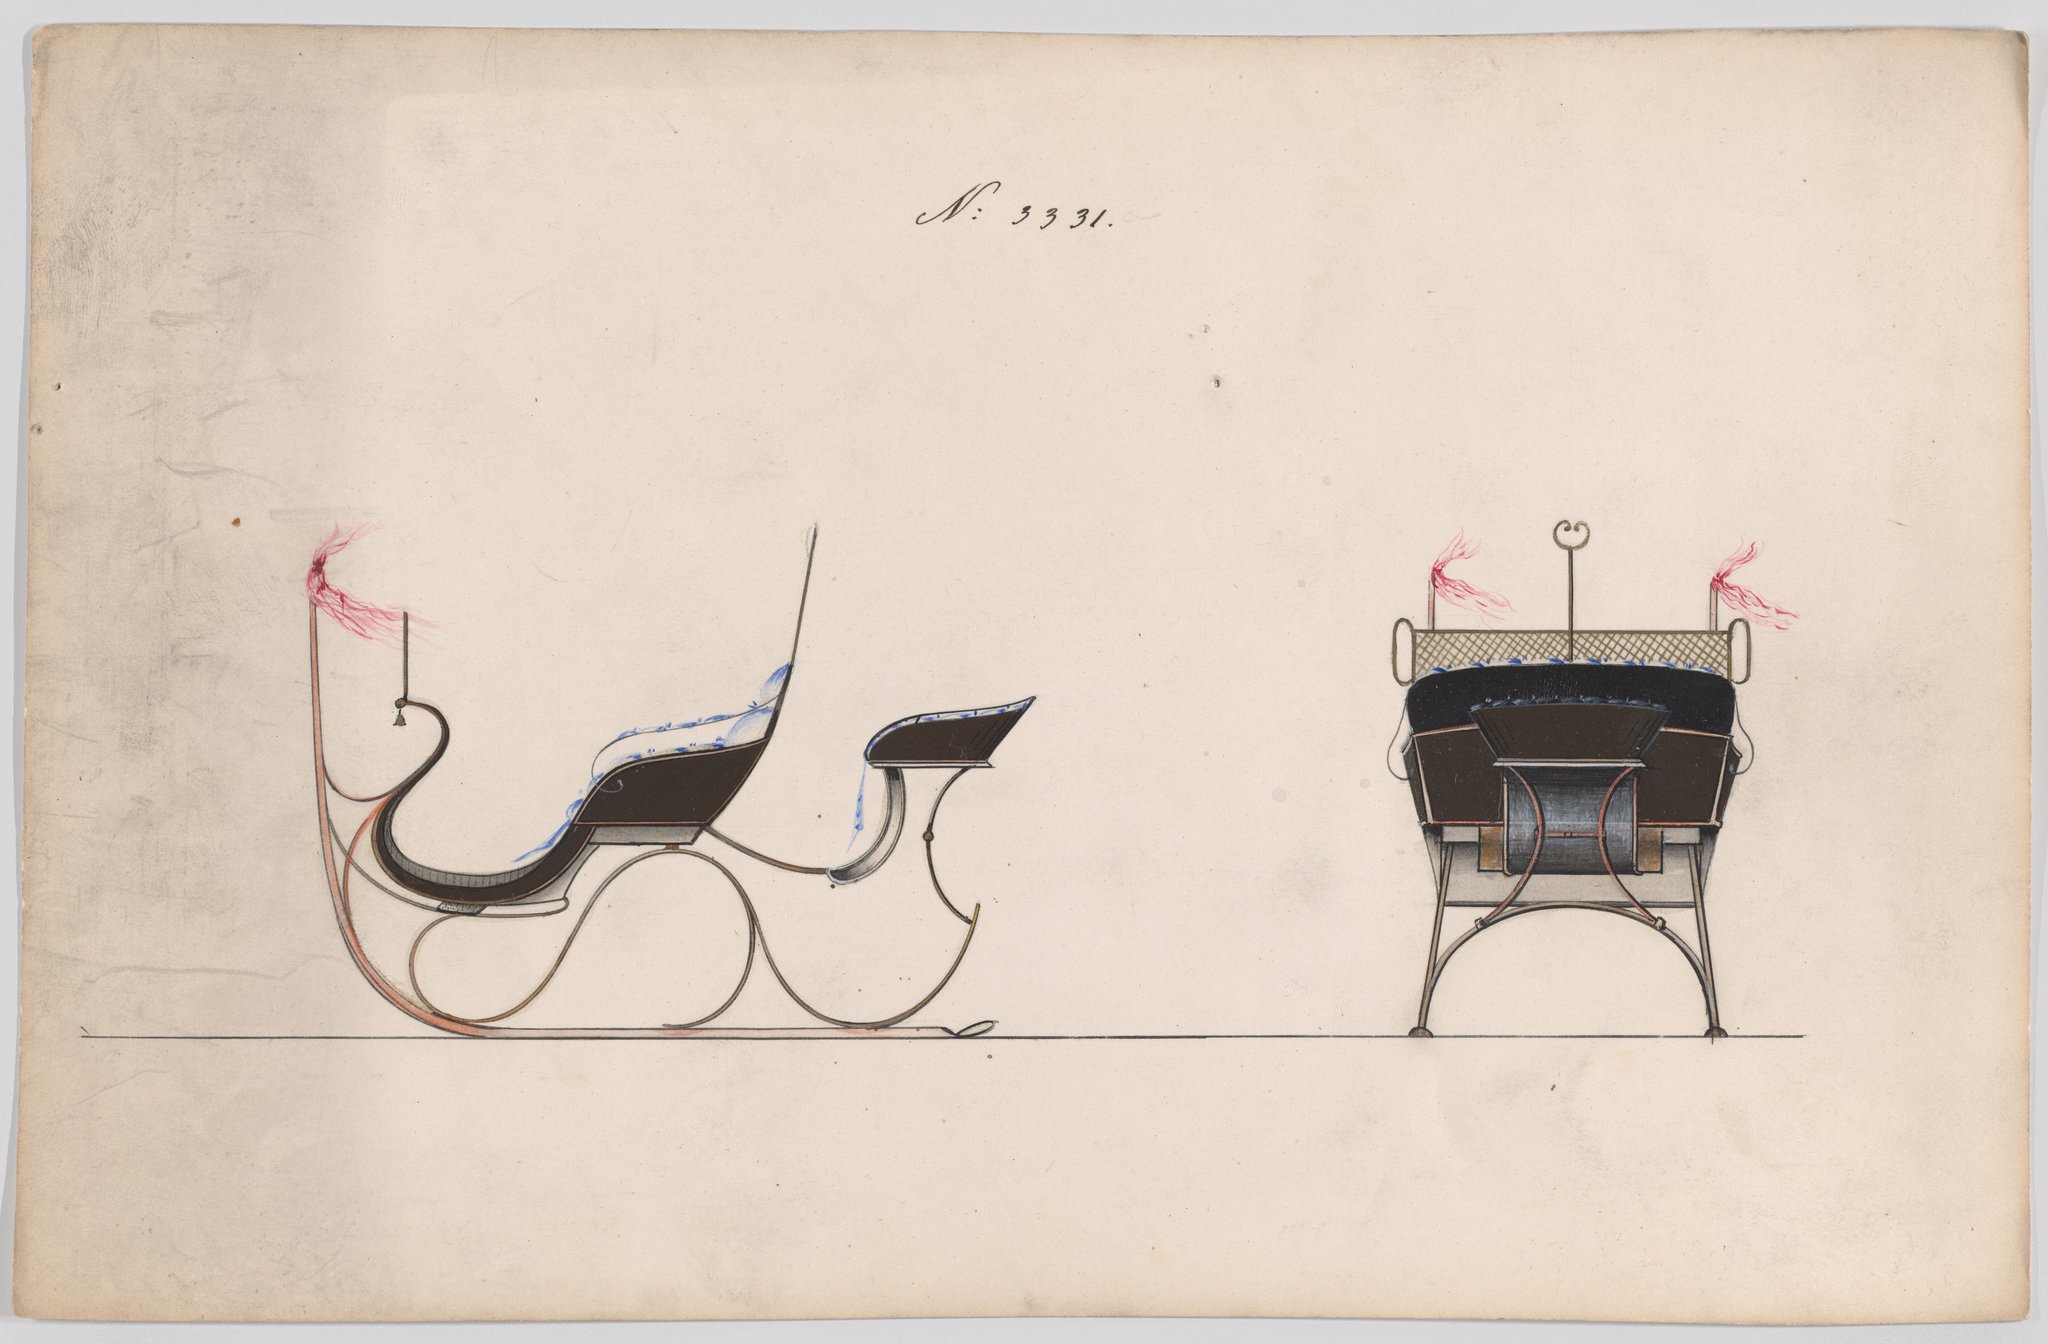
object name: drawing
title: Design for Rumble Sleigh, no. 3331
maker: brewster & co.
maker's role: manufacturer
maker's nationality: american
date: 1877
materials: gouache, gum arabic, ink, watercolor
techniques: pen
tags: sleighs